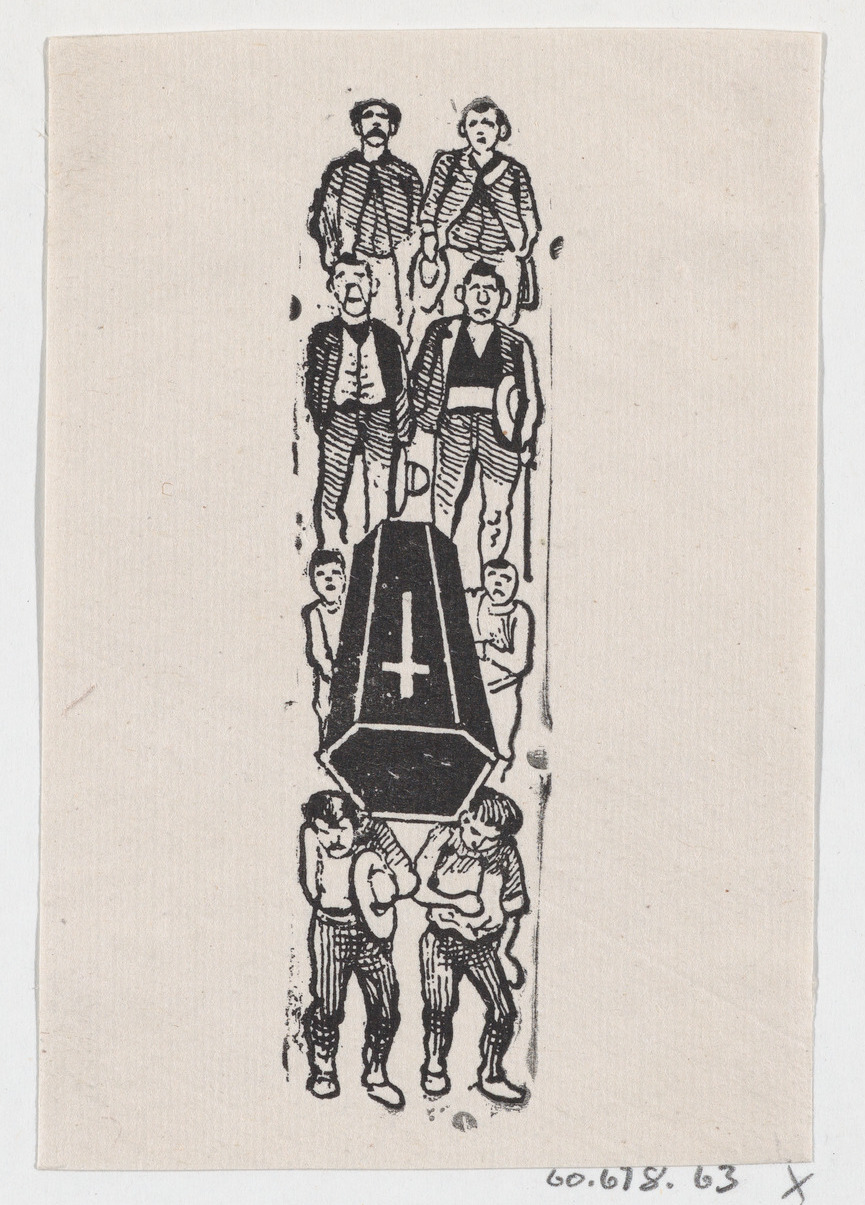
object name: print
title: A group of men carrying a coffin with a cross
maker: josé guadalupe posada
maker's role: artist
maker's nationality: mexican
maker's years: 1852-1913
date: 1880-1910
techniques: lithography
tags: men,cross,burials